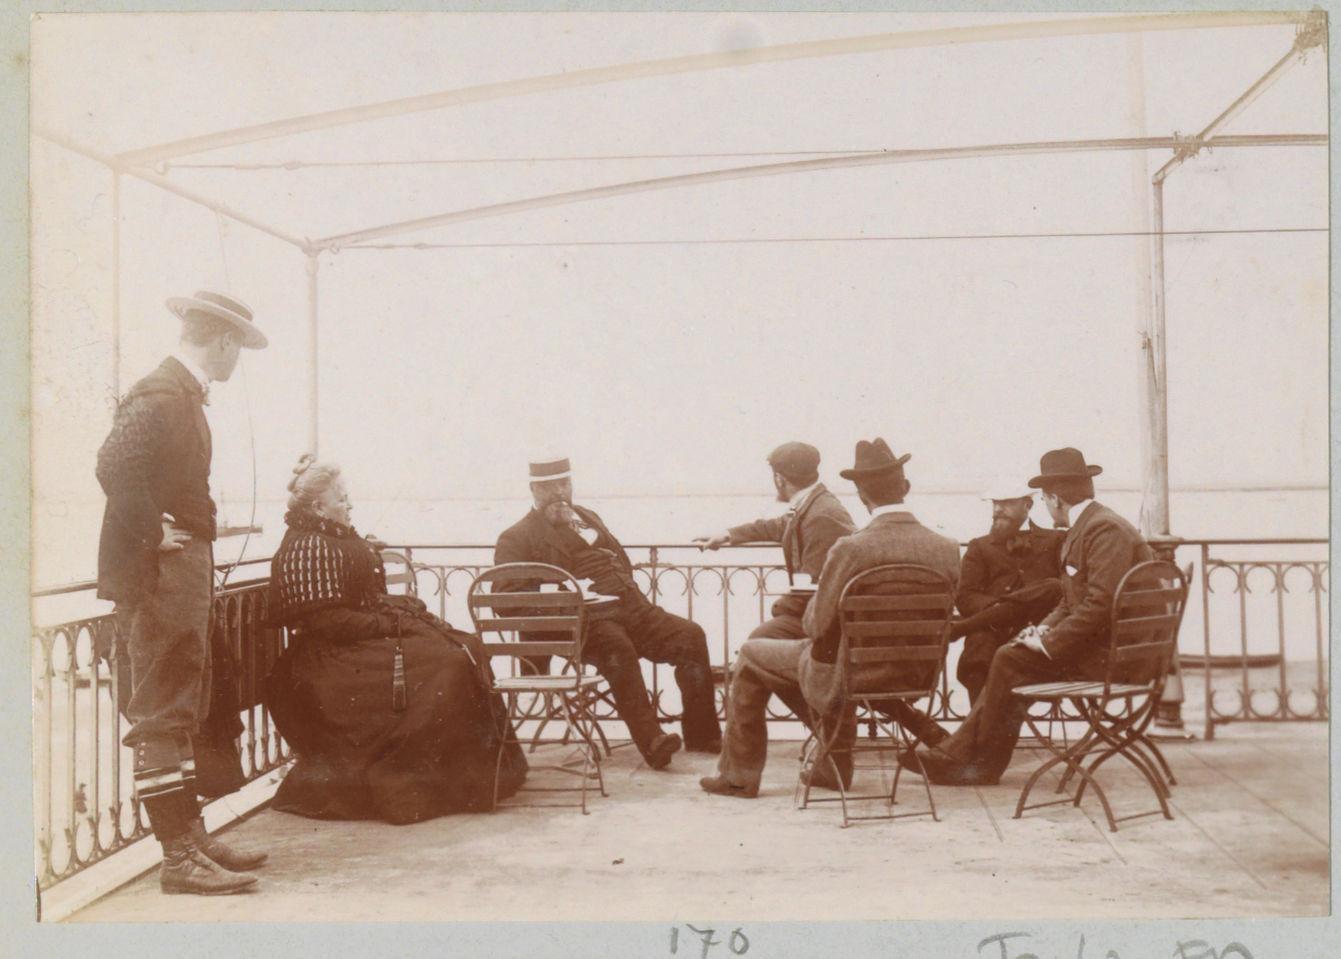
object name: photograph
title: Gezelschap op een terras, vermoedelijk bij Arcachon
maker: delizy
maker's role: manufacturer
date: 1898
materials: paper, photographic support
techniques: gelatin silver print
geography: arcachon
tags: inn, coffee-house, public house, etc., terrace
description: Onderdeel van Fotoalbum van een Franse amateurfotograaf met opnames van uitstapjes in Frankrijk, Spanje, België, Luxemburg en Nederland, de eerste automobielen en autoraces.